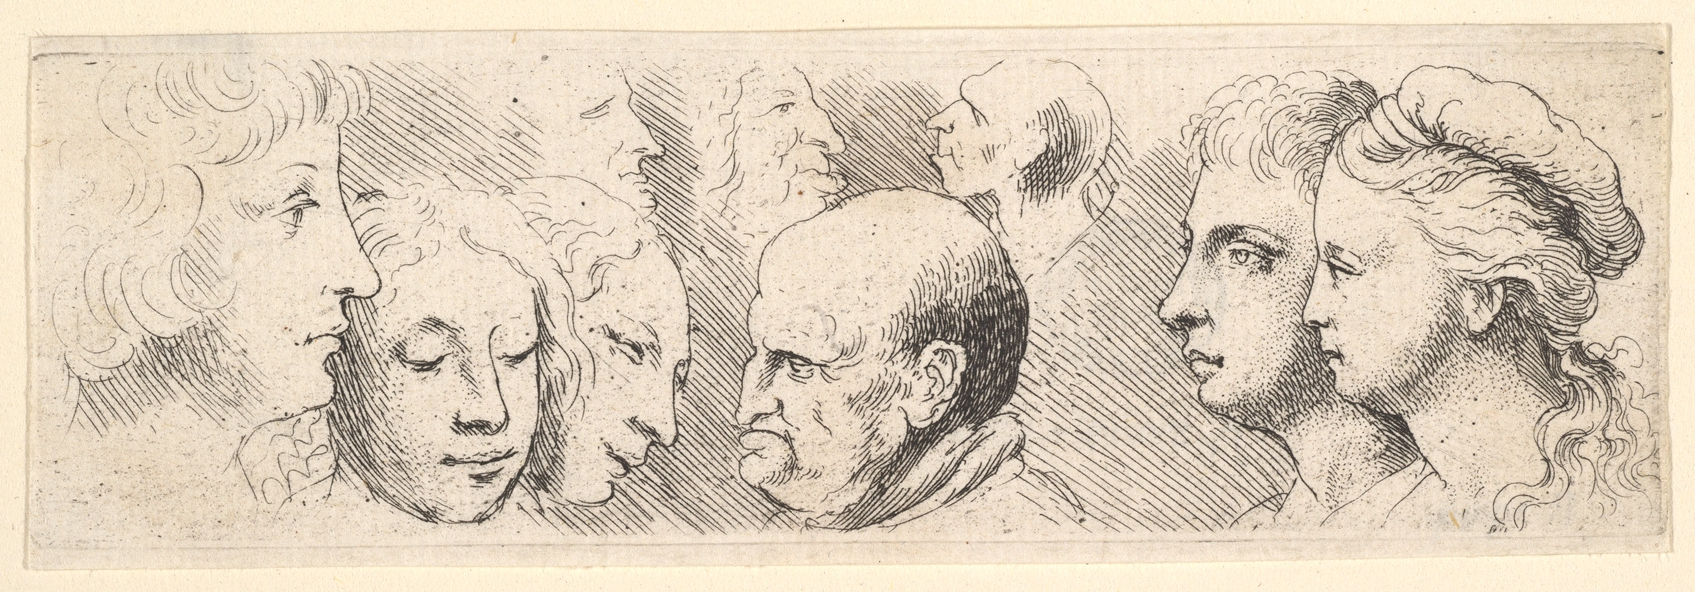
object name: print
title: Nine Heads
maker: wenceslaus hollar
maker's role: artist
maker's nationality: bohemian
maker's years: 1607-1677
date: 1644-1652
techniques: etching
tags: heads,profiles